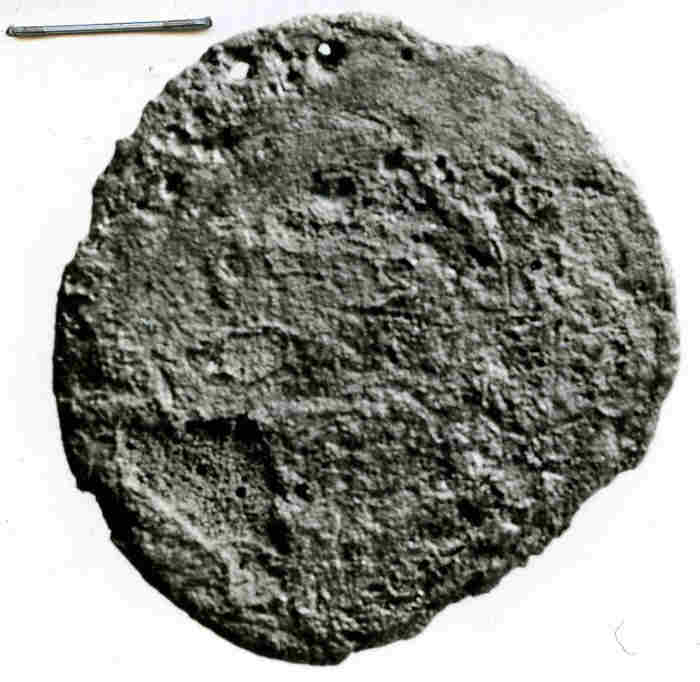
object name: coin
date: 701-800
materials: copper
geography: iran